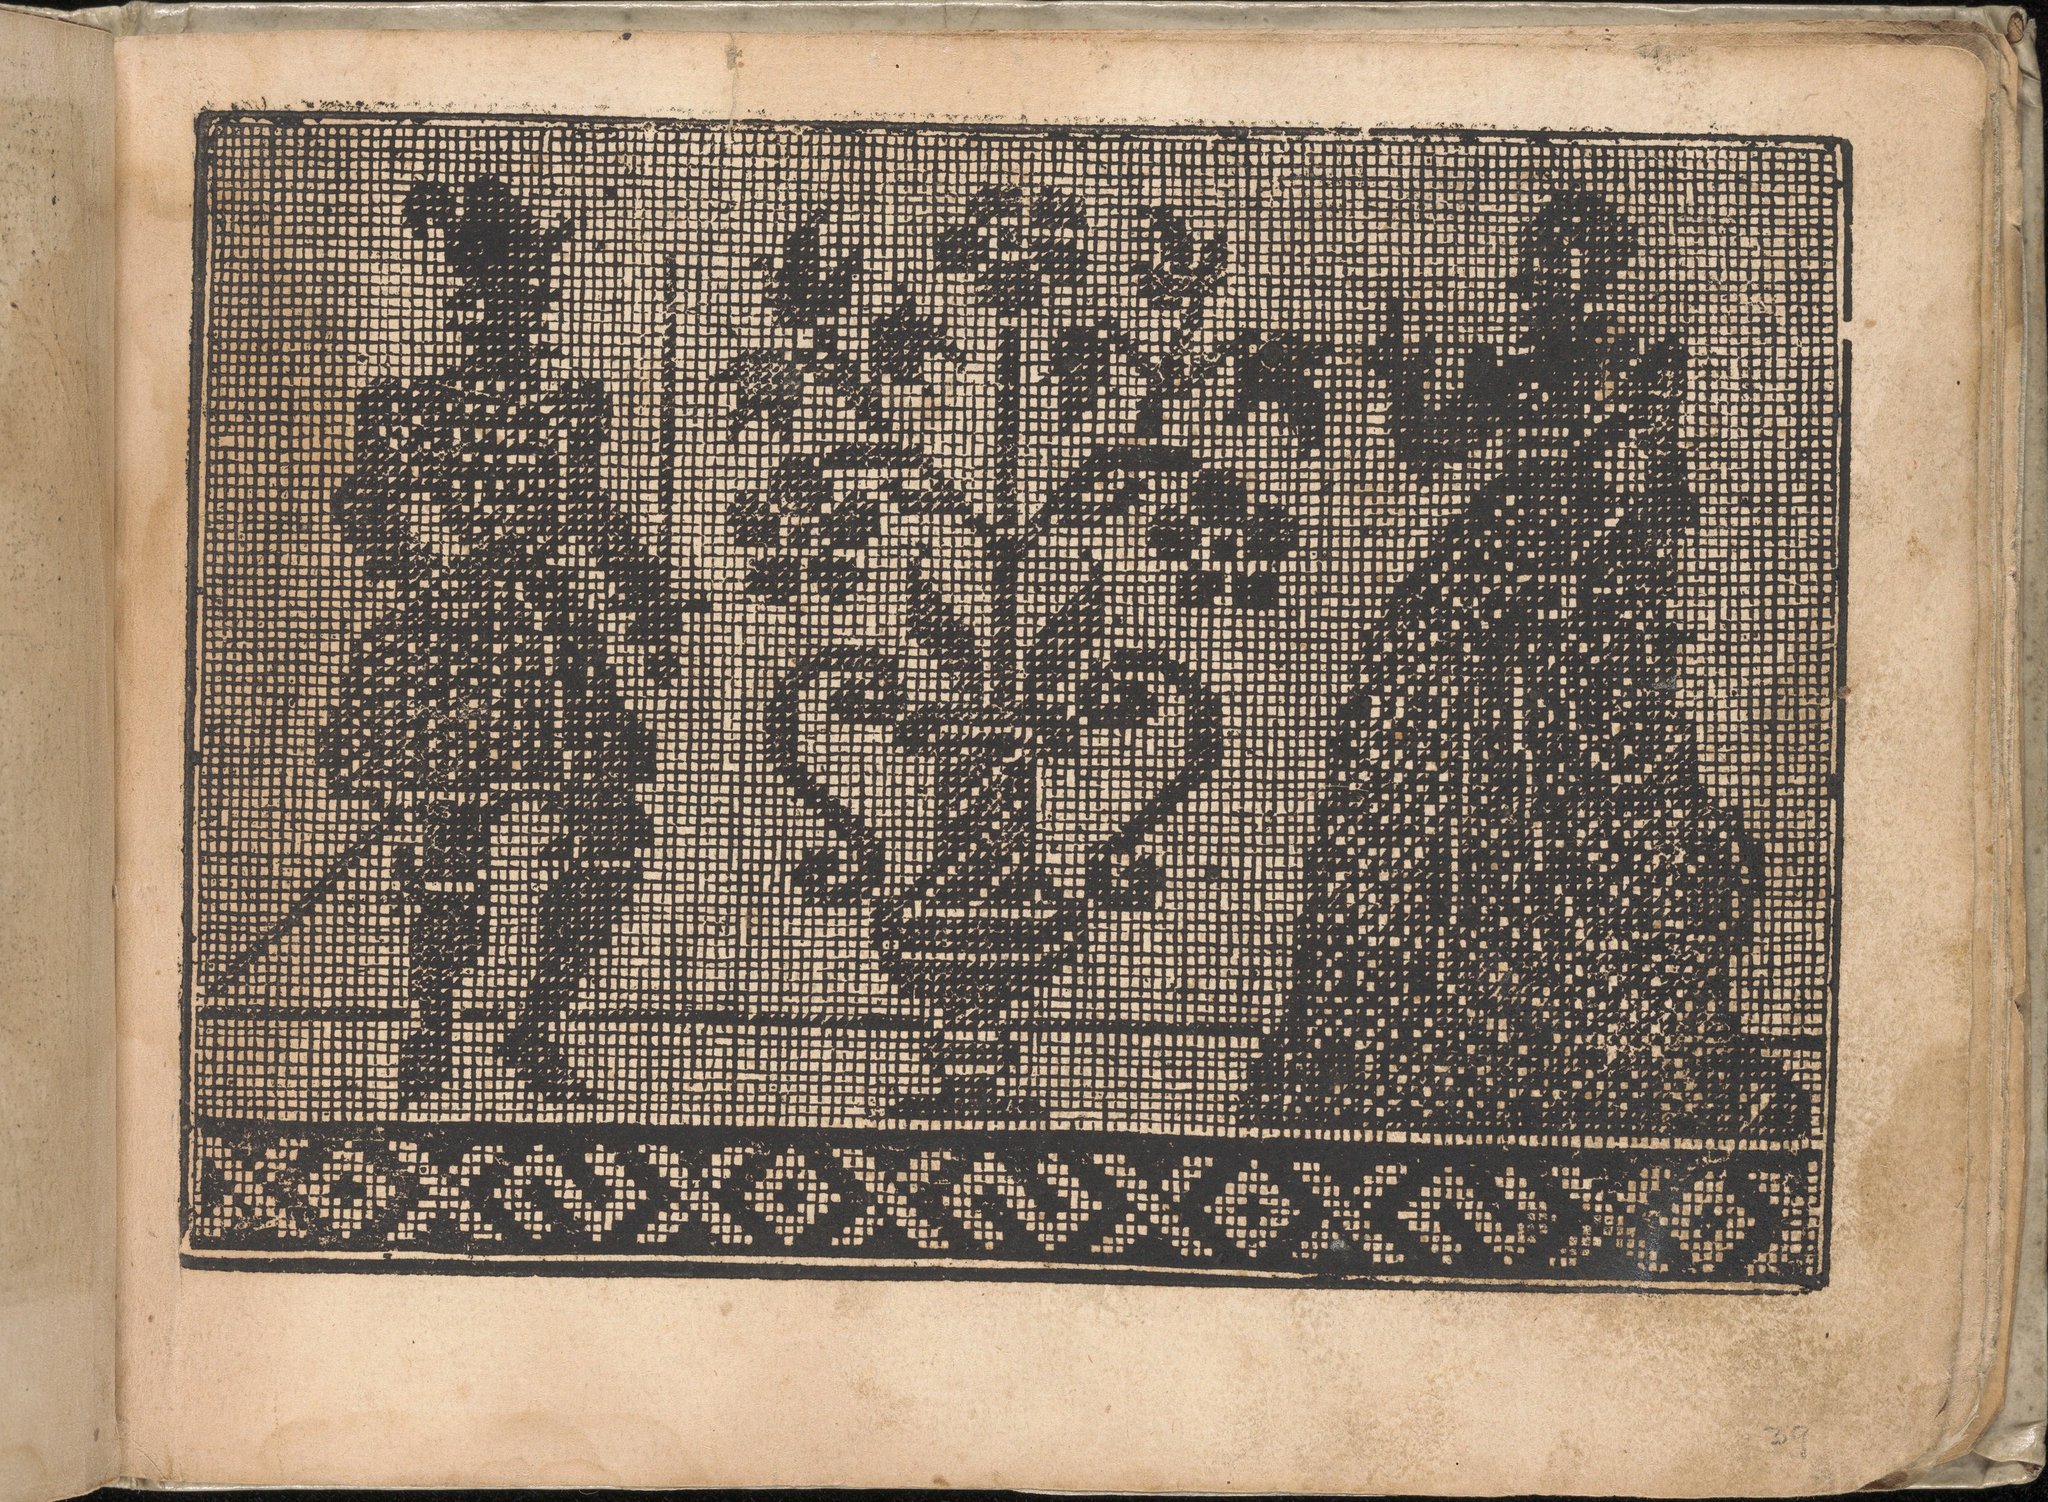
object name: book print ornament architecture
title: Neu künstlich Modelbuch (page 39r)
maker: bernhard jobin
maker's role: publisher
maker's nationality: swiss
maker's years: 1535-1597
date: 1598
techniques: woodcut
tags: men,women,flowers